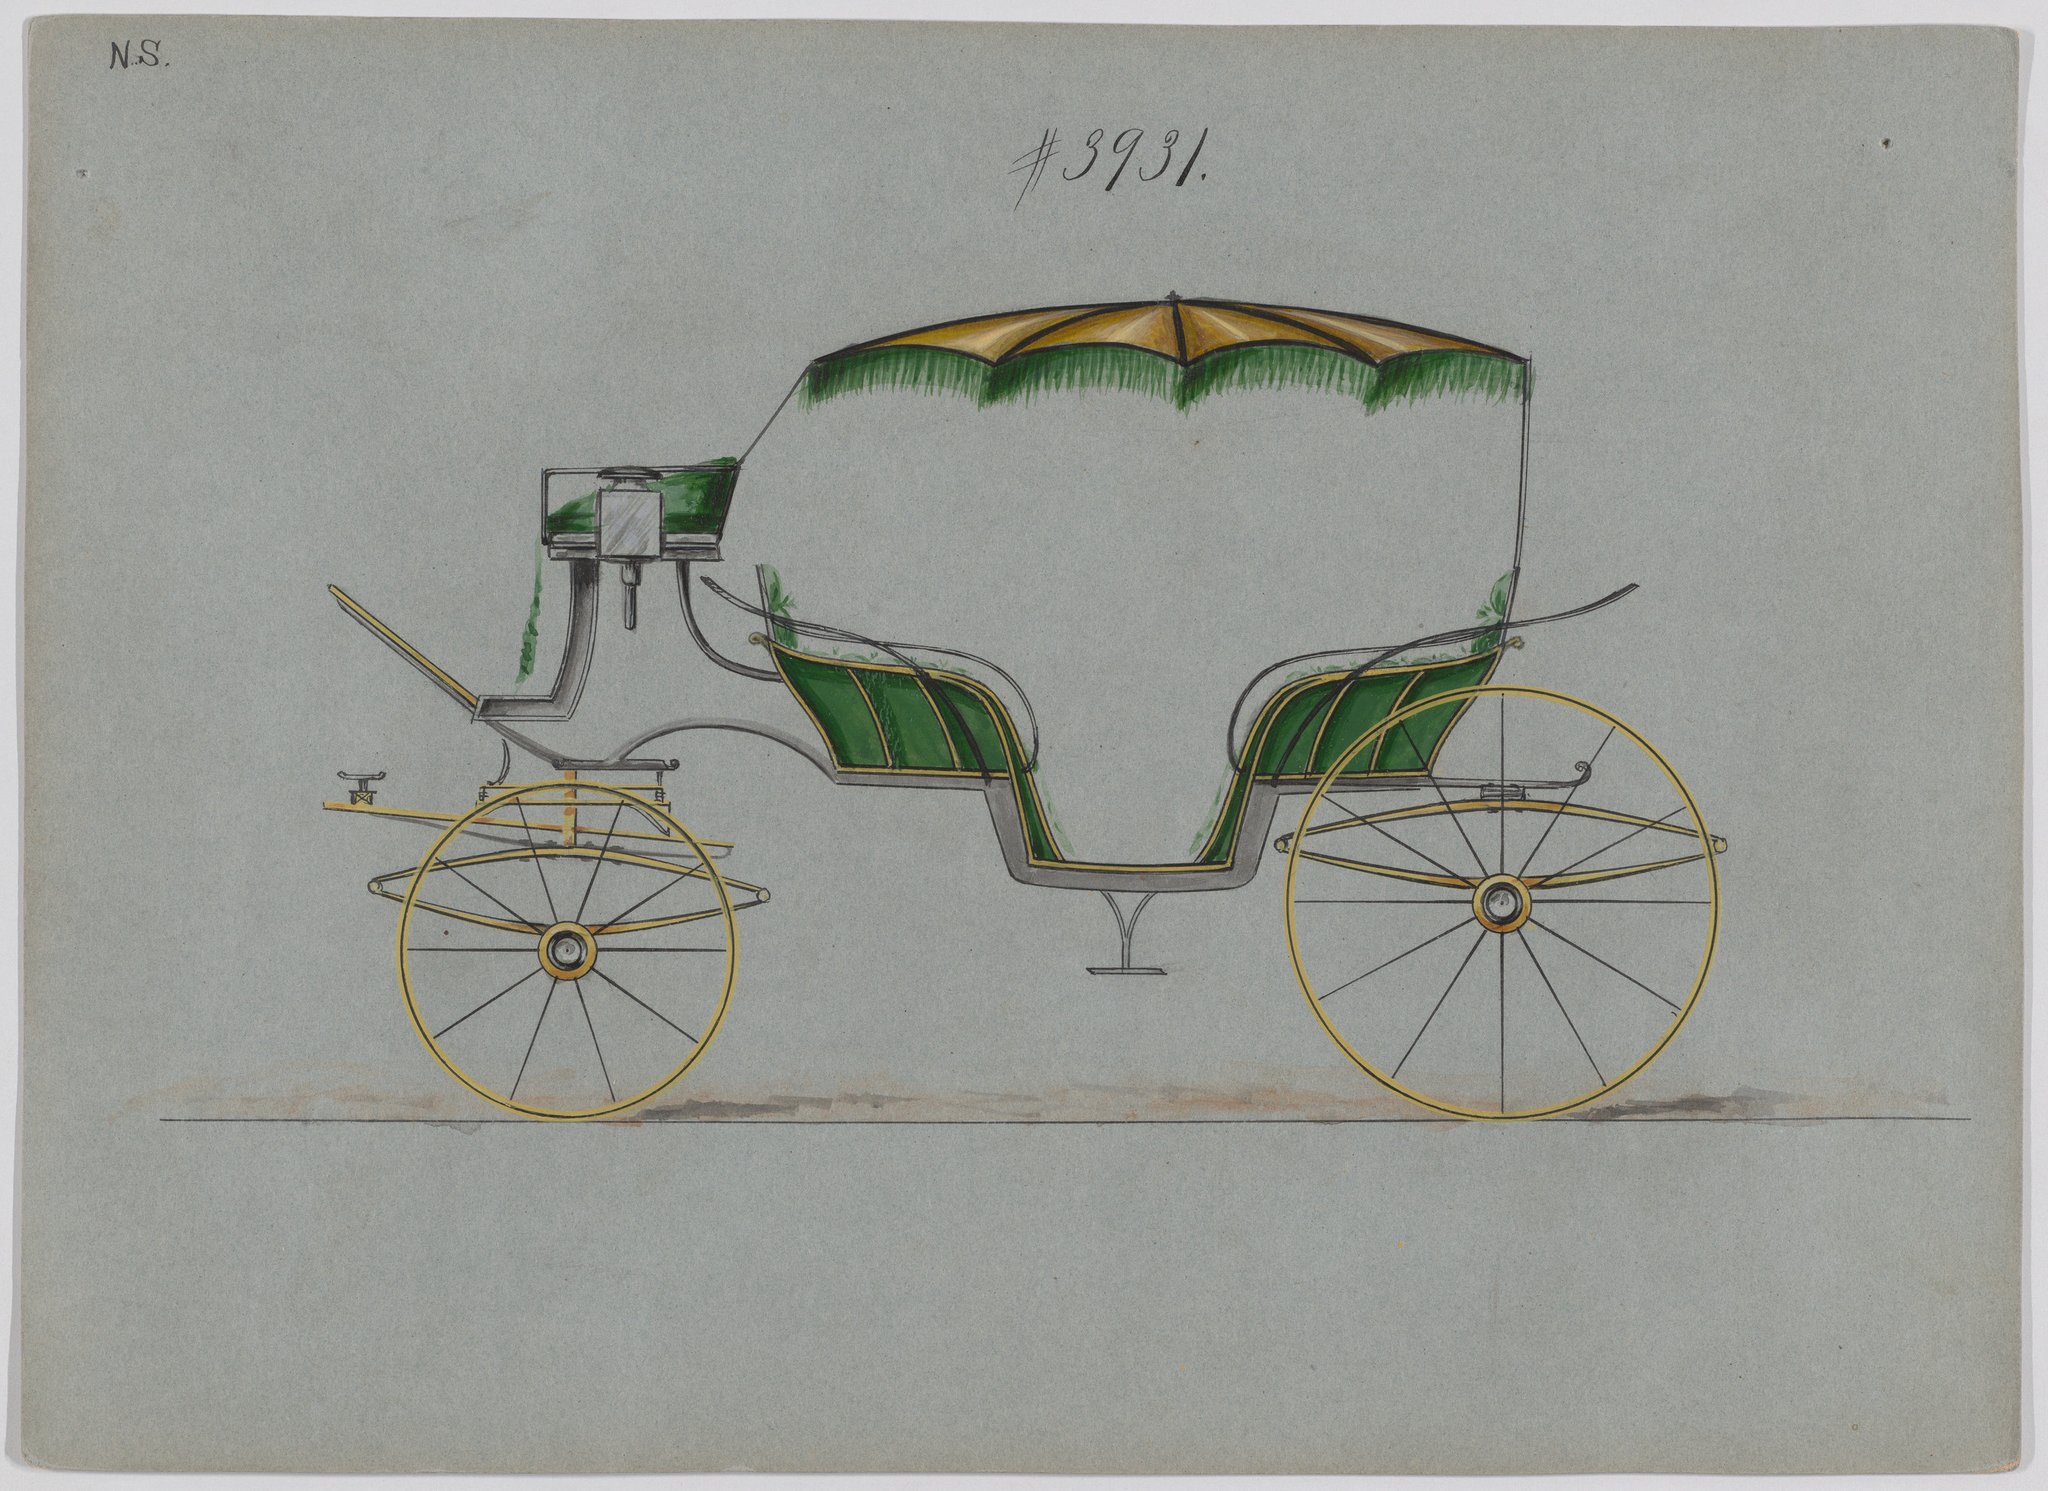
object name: drawing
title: Parasol Top Vis-a-Vis #3931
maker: brewster & co.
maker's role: manufacturer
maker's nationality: american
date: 1884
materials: gouache, gum arabic, watercolor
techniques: pen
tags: carriages